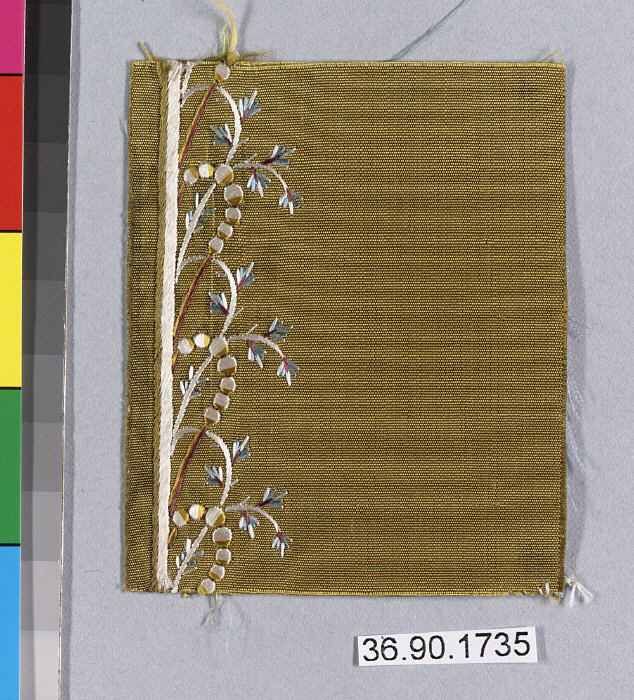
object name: sample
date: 1801-1833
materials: silk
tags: plants